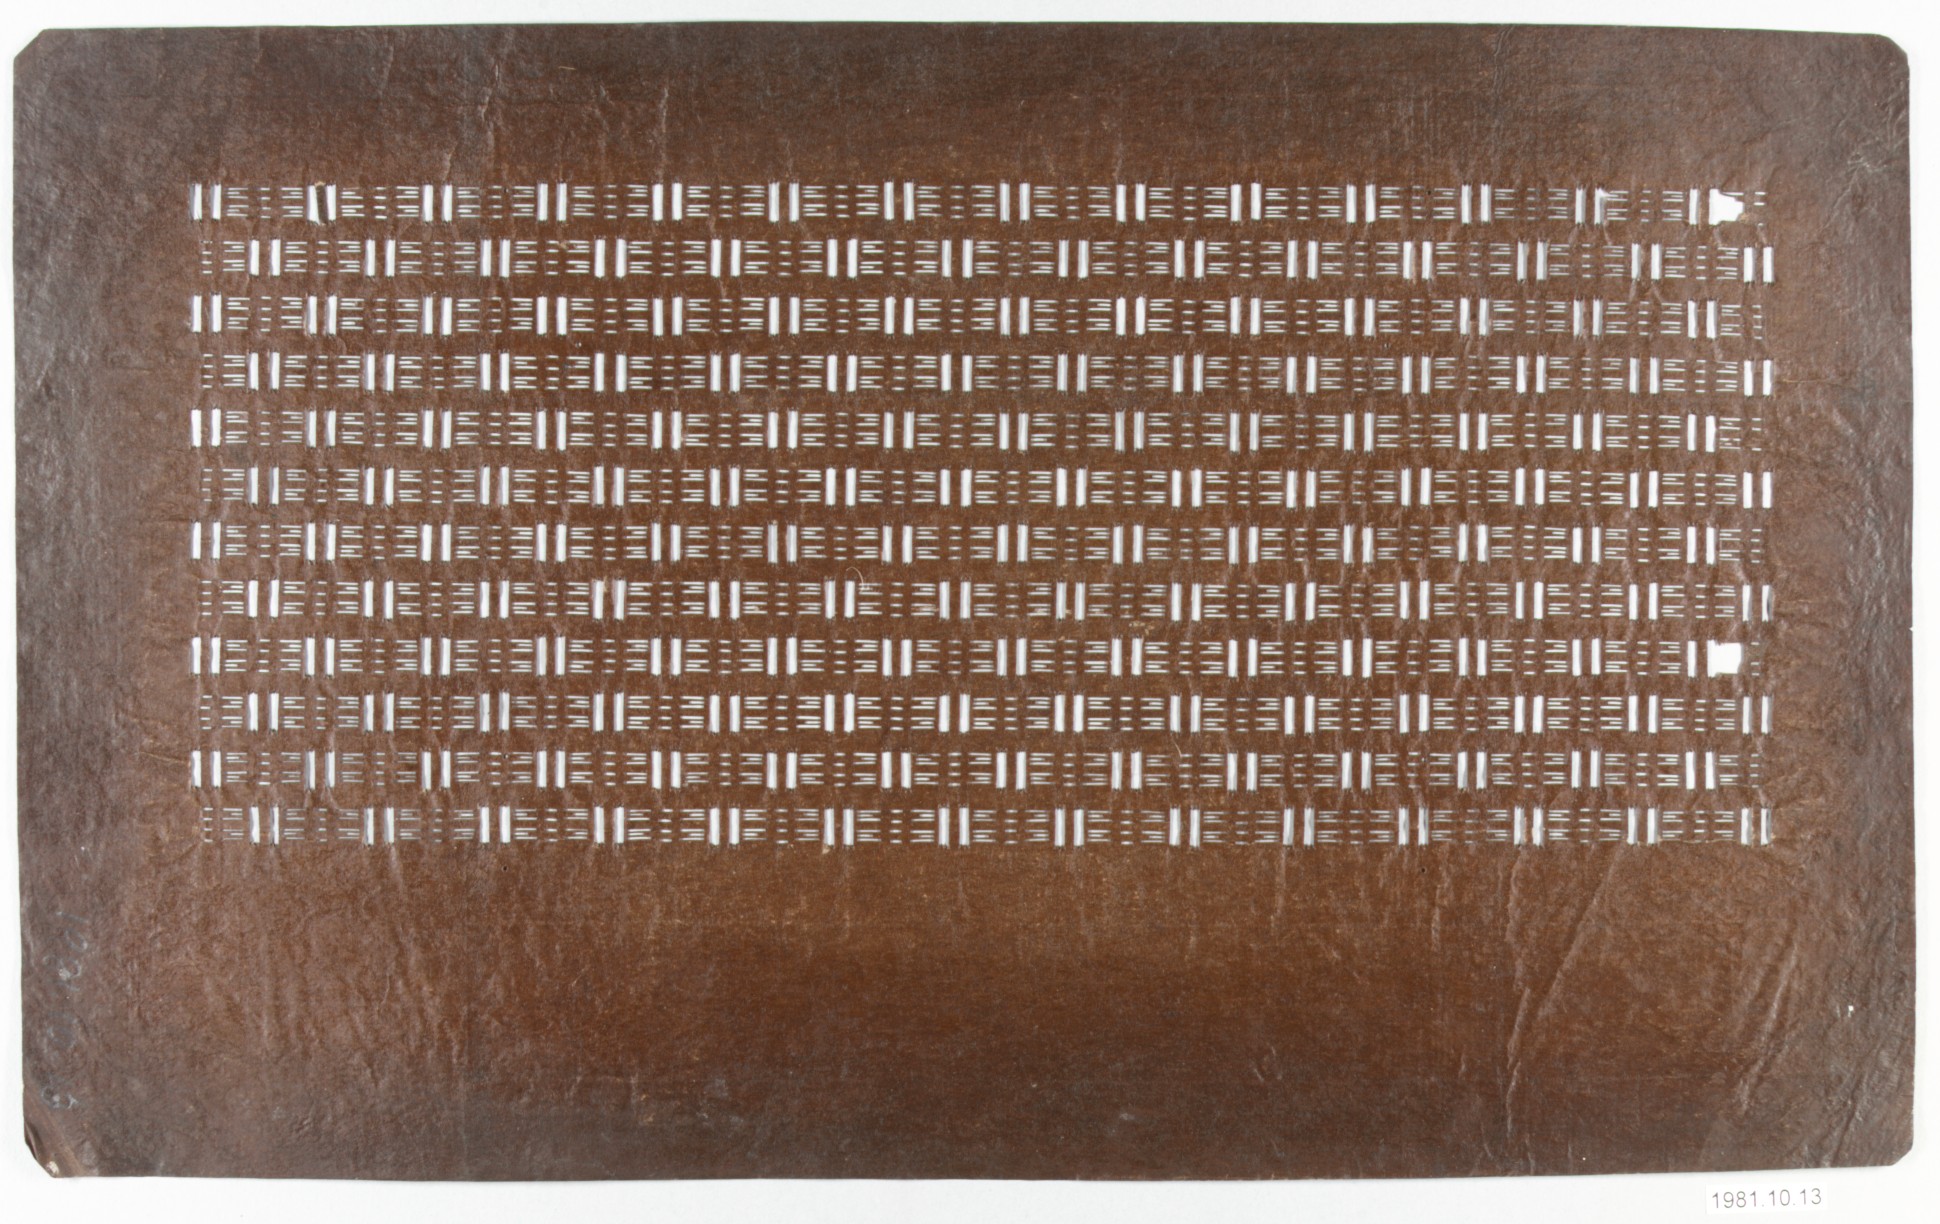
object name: stencil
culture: japanese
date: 1801-1900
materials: paper